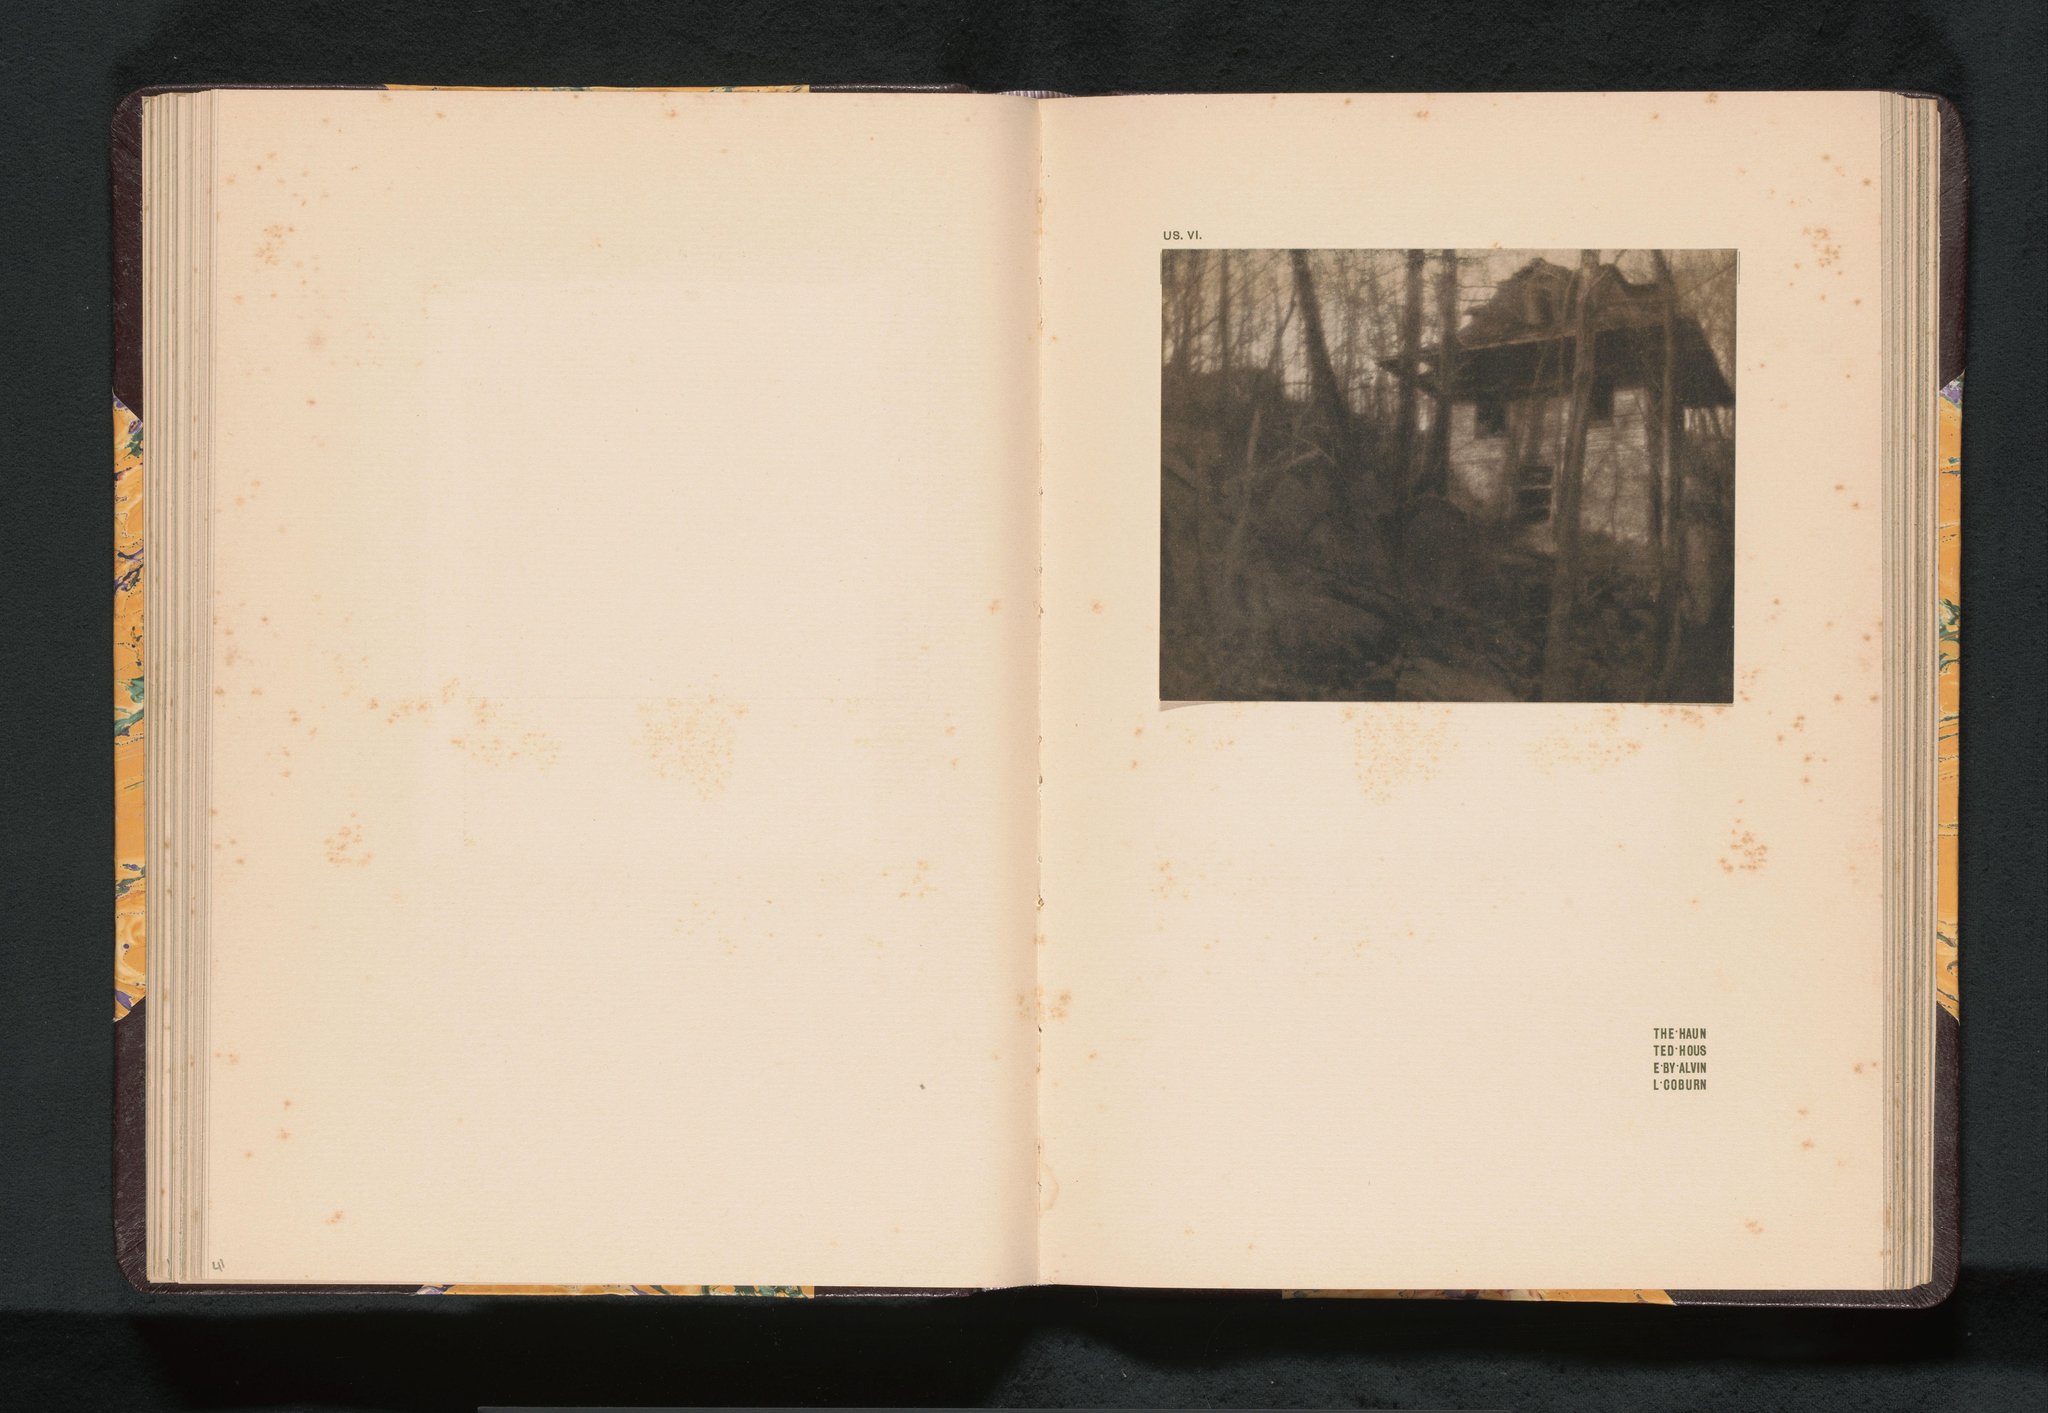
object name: page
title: Huis in een bos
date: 1900-1905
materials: paper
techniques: two-color autotype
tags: rural housing, e.g. country-house, villa, cottage, forest, wood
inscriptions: inscription: ‘US. VI.’, inscription: ‘The haunted house by Alvin L Coburn’